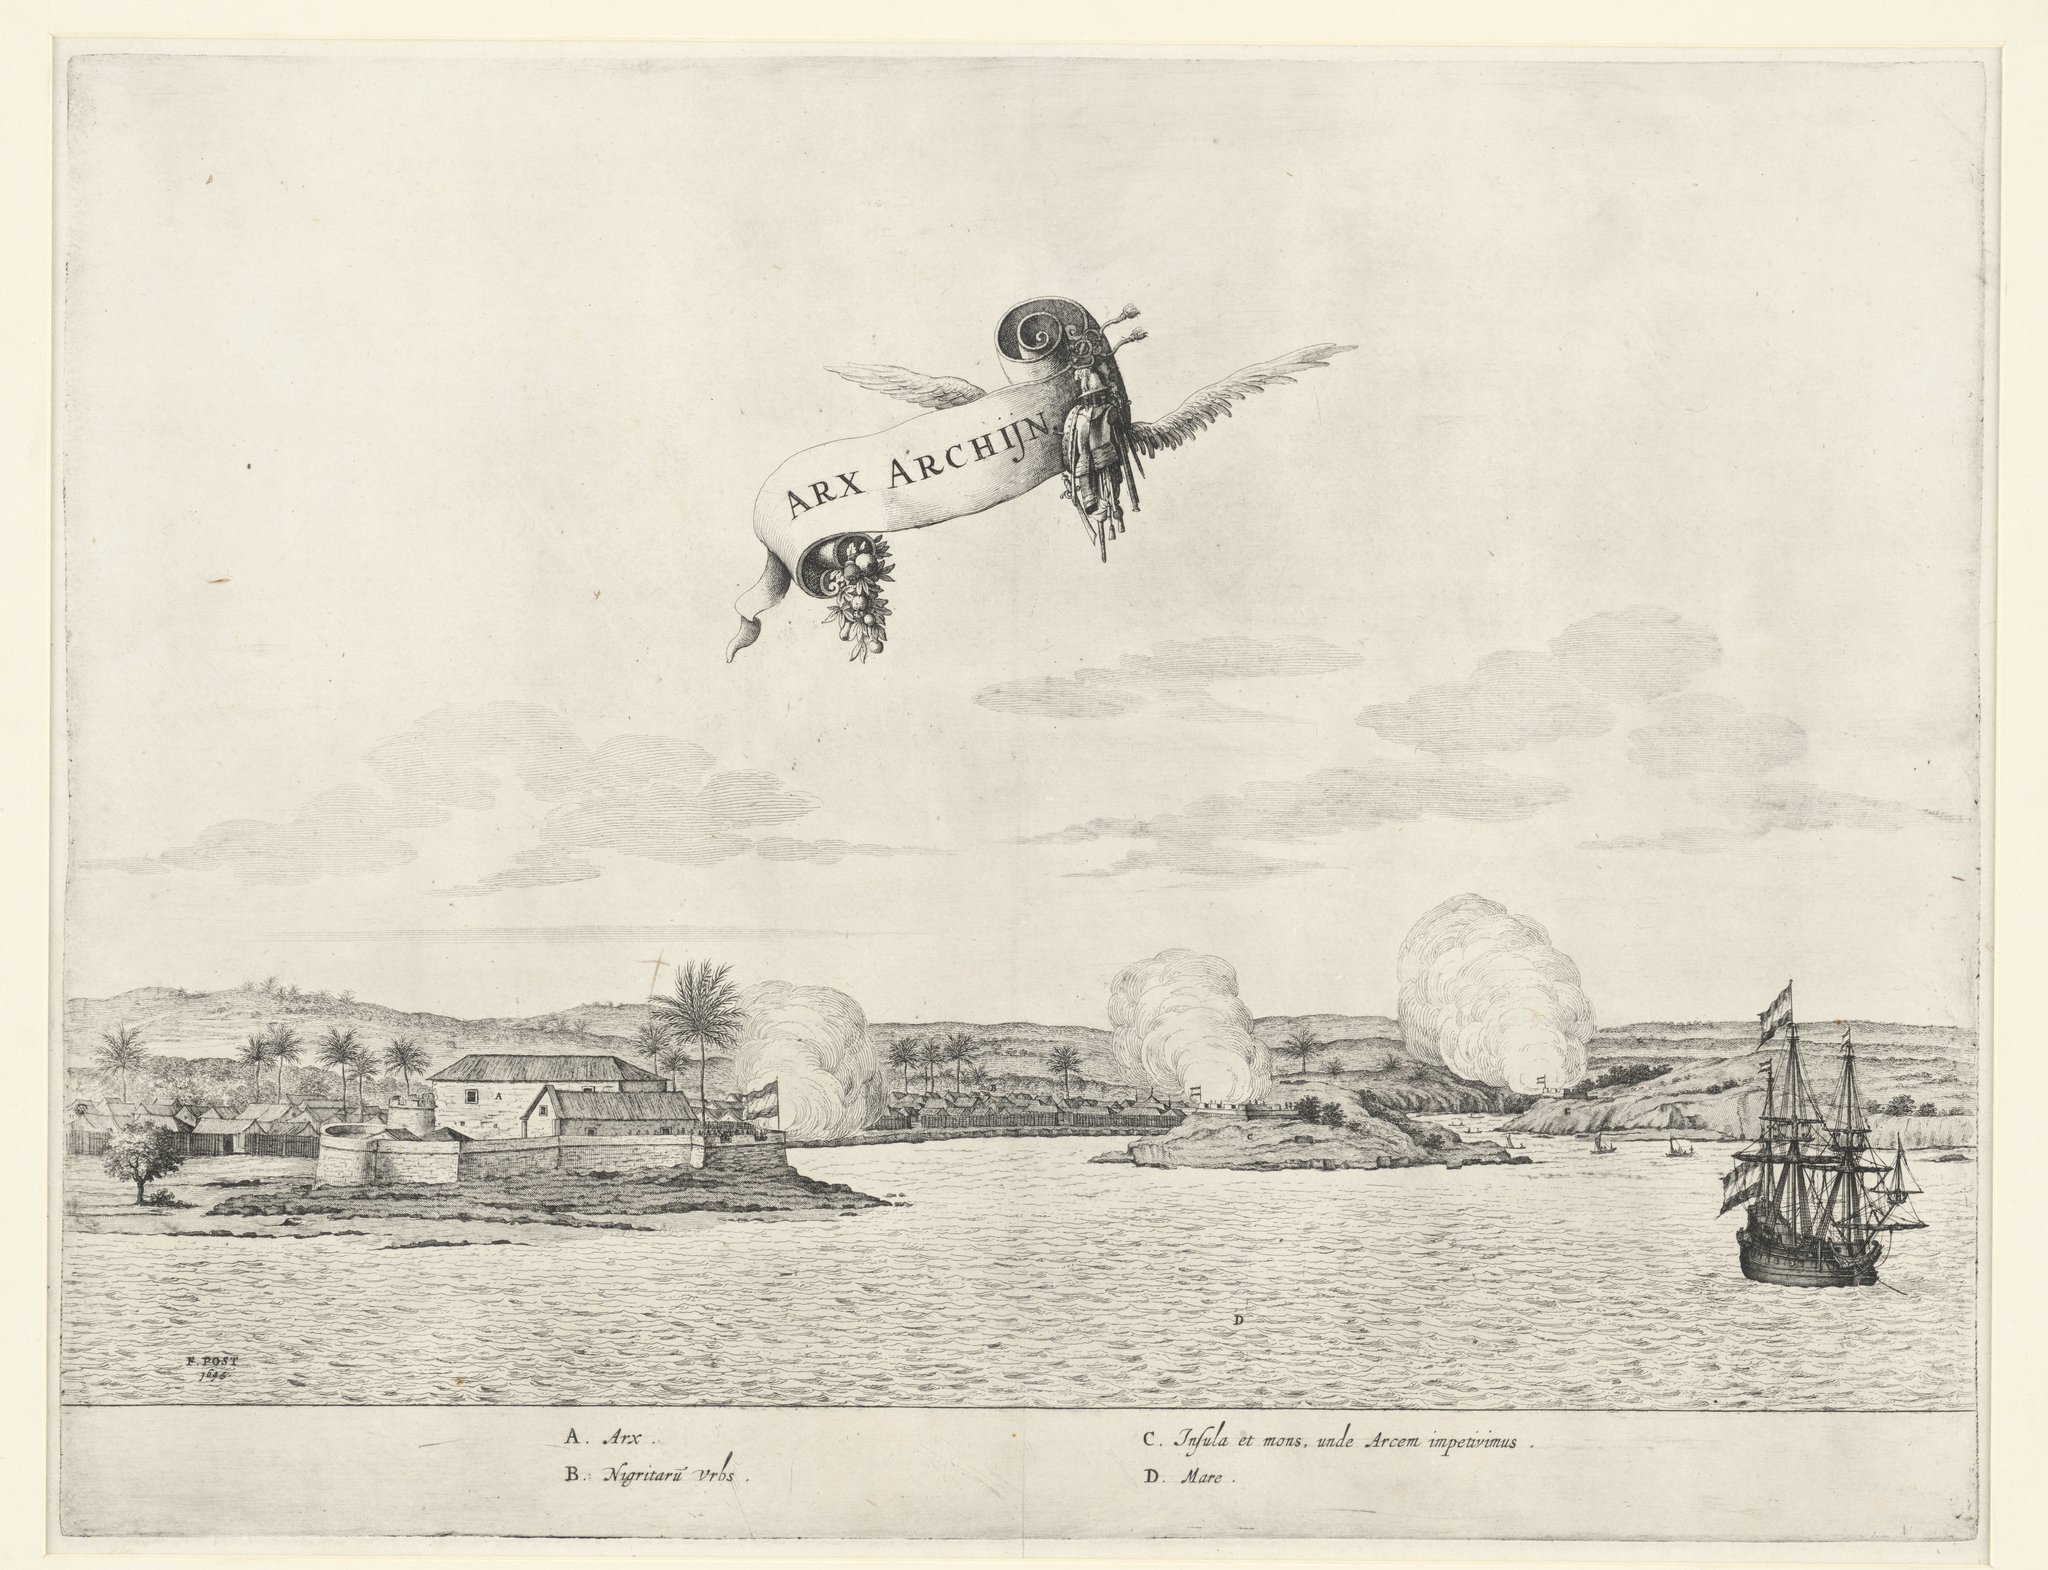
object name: book illustration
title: Arx Archijn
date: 1645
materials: paper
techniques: engraving, etching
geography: netherlands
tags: earl, johan maurits graaf van nassau-siegen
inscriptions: collector's mark: Lugt 2228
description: nrs. 60. 75 uit verz. Fred. Muller. Cat. 1891. Prent toont grote overeenkomsten met prenten in de uitgave van Johannes Blaeu met serie van 55 voorstellingen van de tocht naar en het verblijf in Brazilië van graaf Johan Maurits van Nassau in de jaren 1636-1644 maar werd niet in deze uitgave opgenomen.